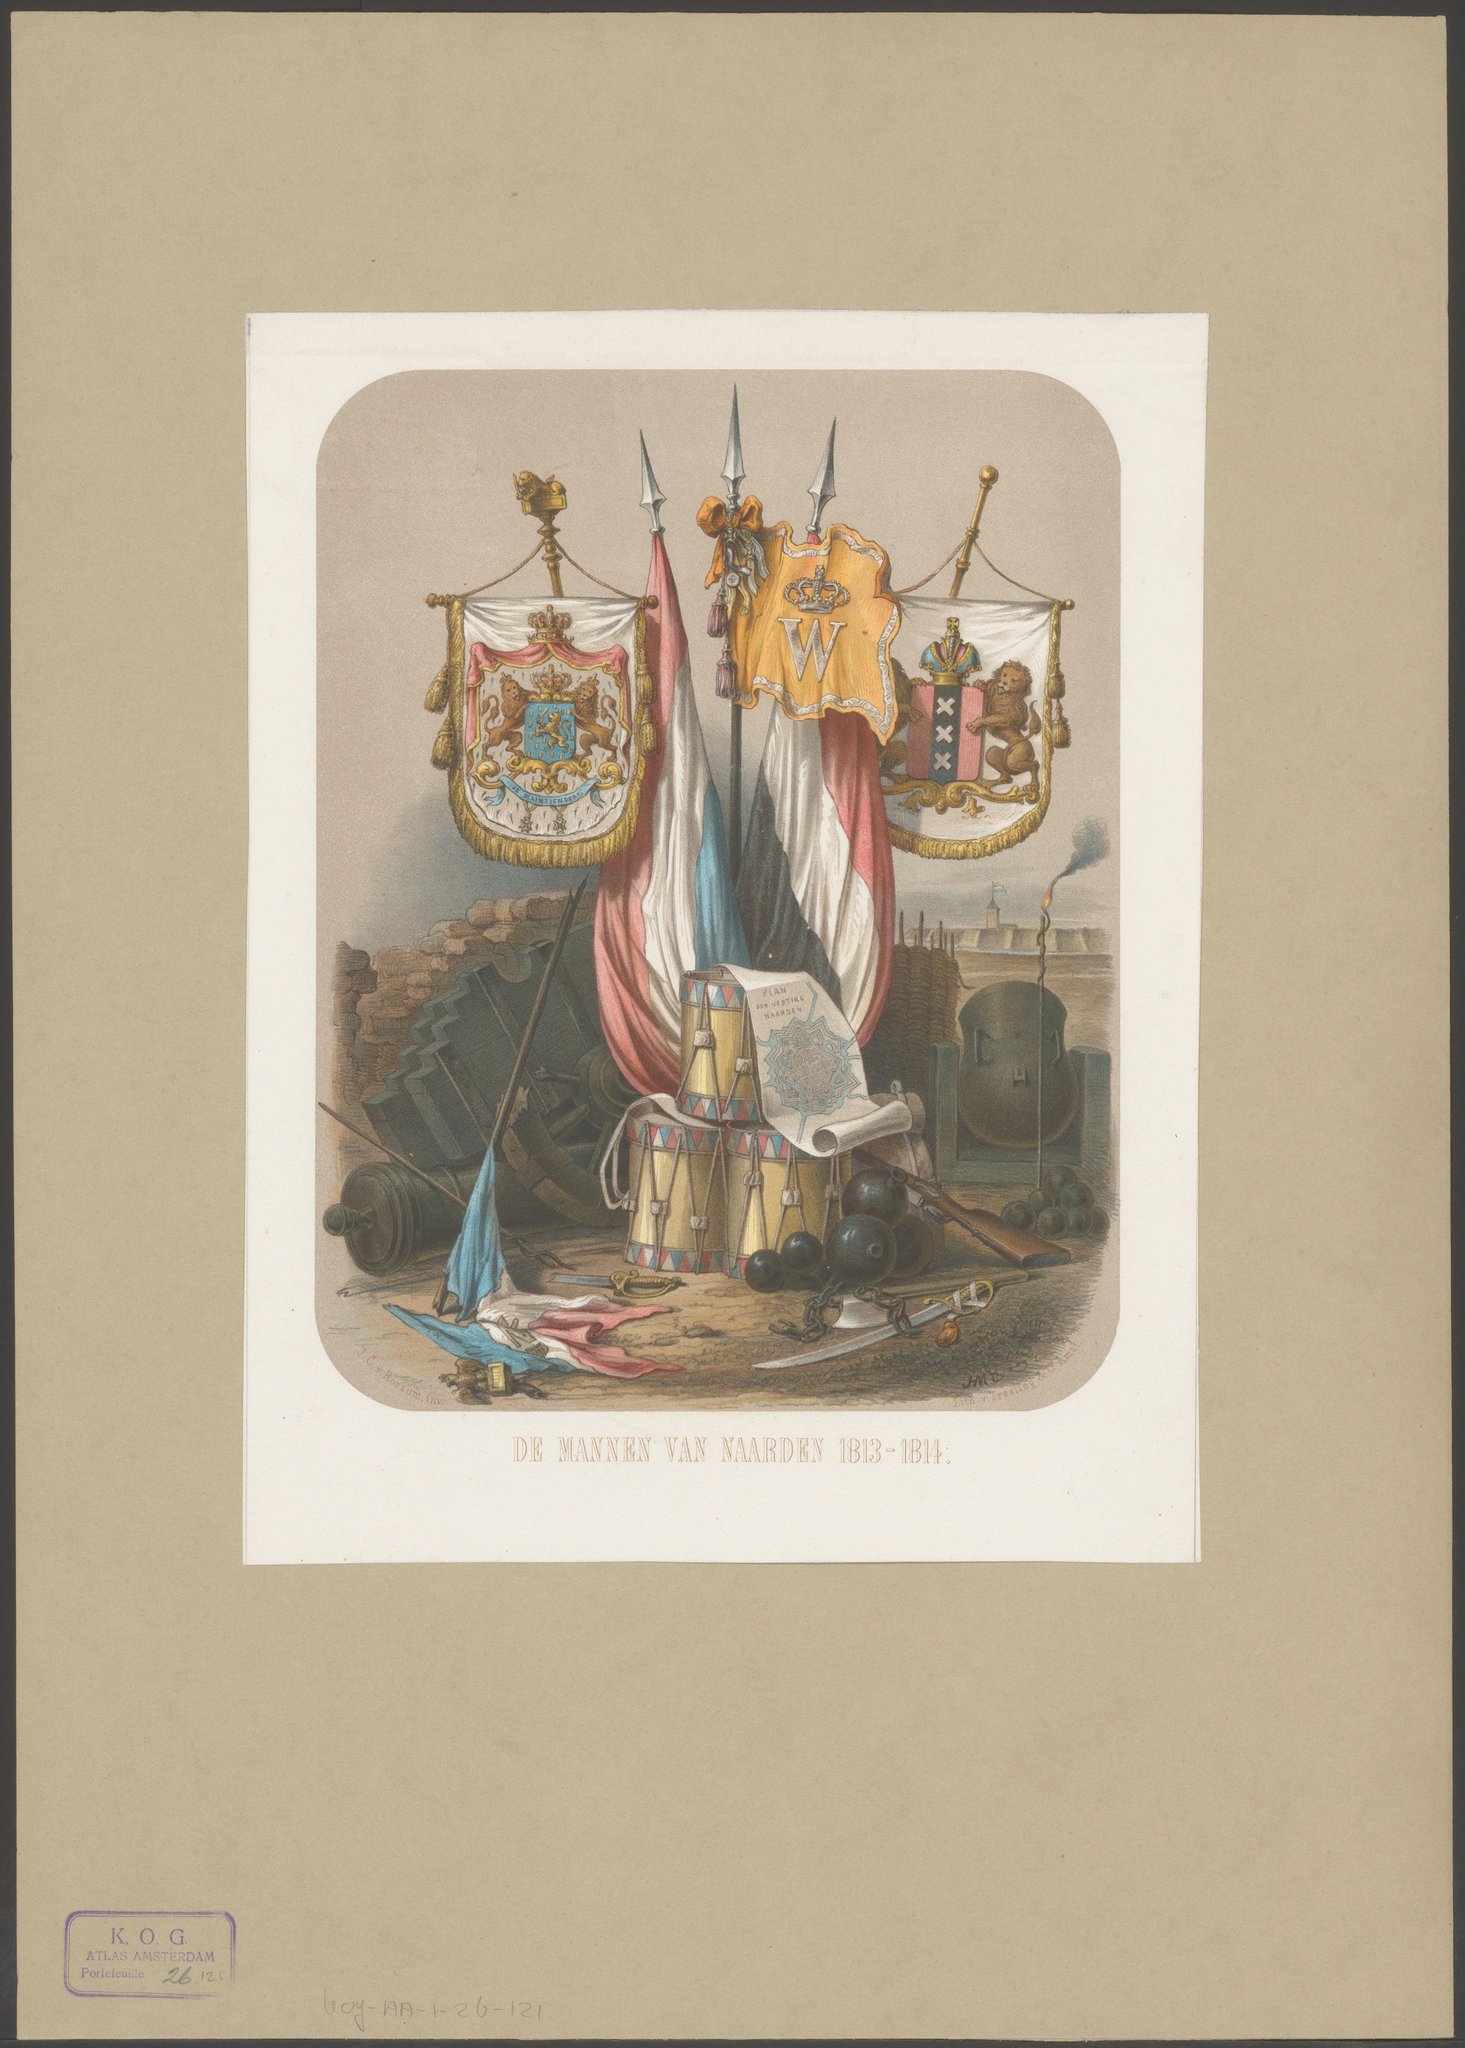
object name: print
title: Herinnering aan het Beleg van Naarden met vaandels, vlaggen, trommels en wapens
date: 1858-1905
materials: paper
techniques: lithograph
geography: amsterdam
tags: coat of arms (as symbol of the state, etc.) (+ city; municipal), drum (musical instrument), firearms: cannon, banner, standard (as symbol of the state, etc.), maps of cities, armorial bearing, heraldry, flag, colours (as symbol of the state, etc.)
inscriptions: collector's mark: Lugt 1641b, signature: ‘JM.CU’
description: Onderwerpsrubriek binnen de Atlas Amsterdam: Herinneringen aan de Schutterij.